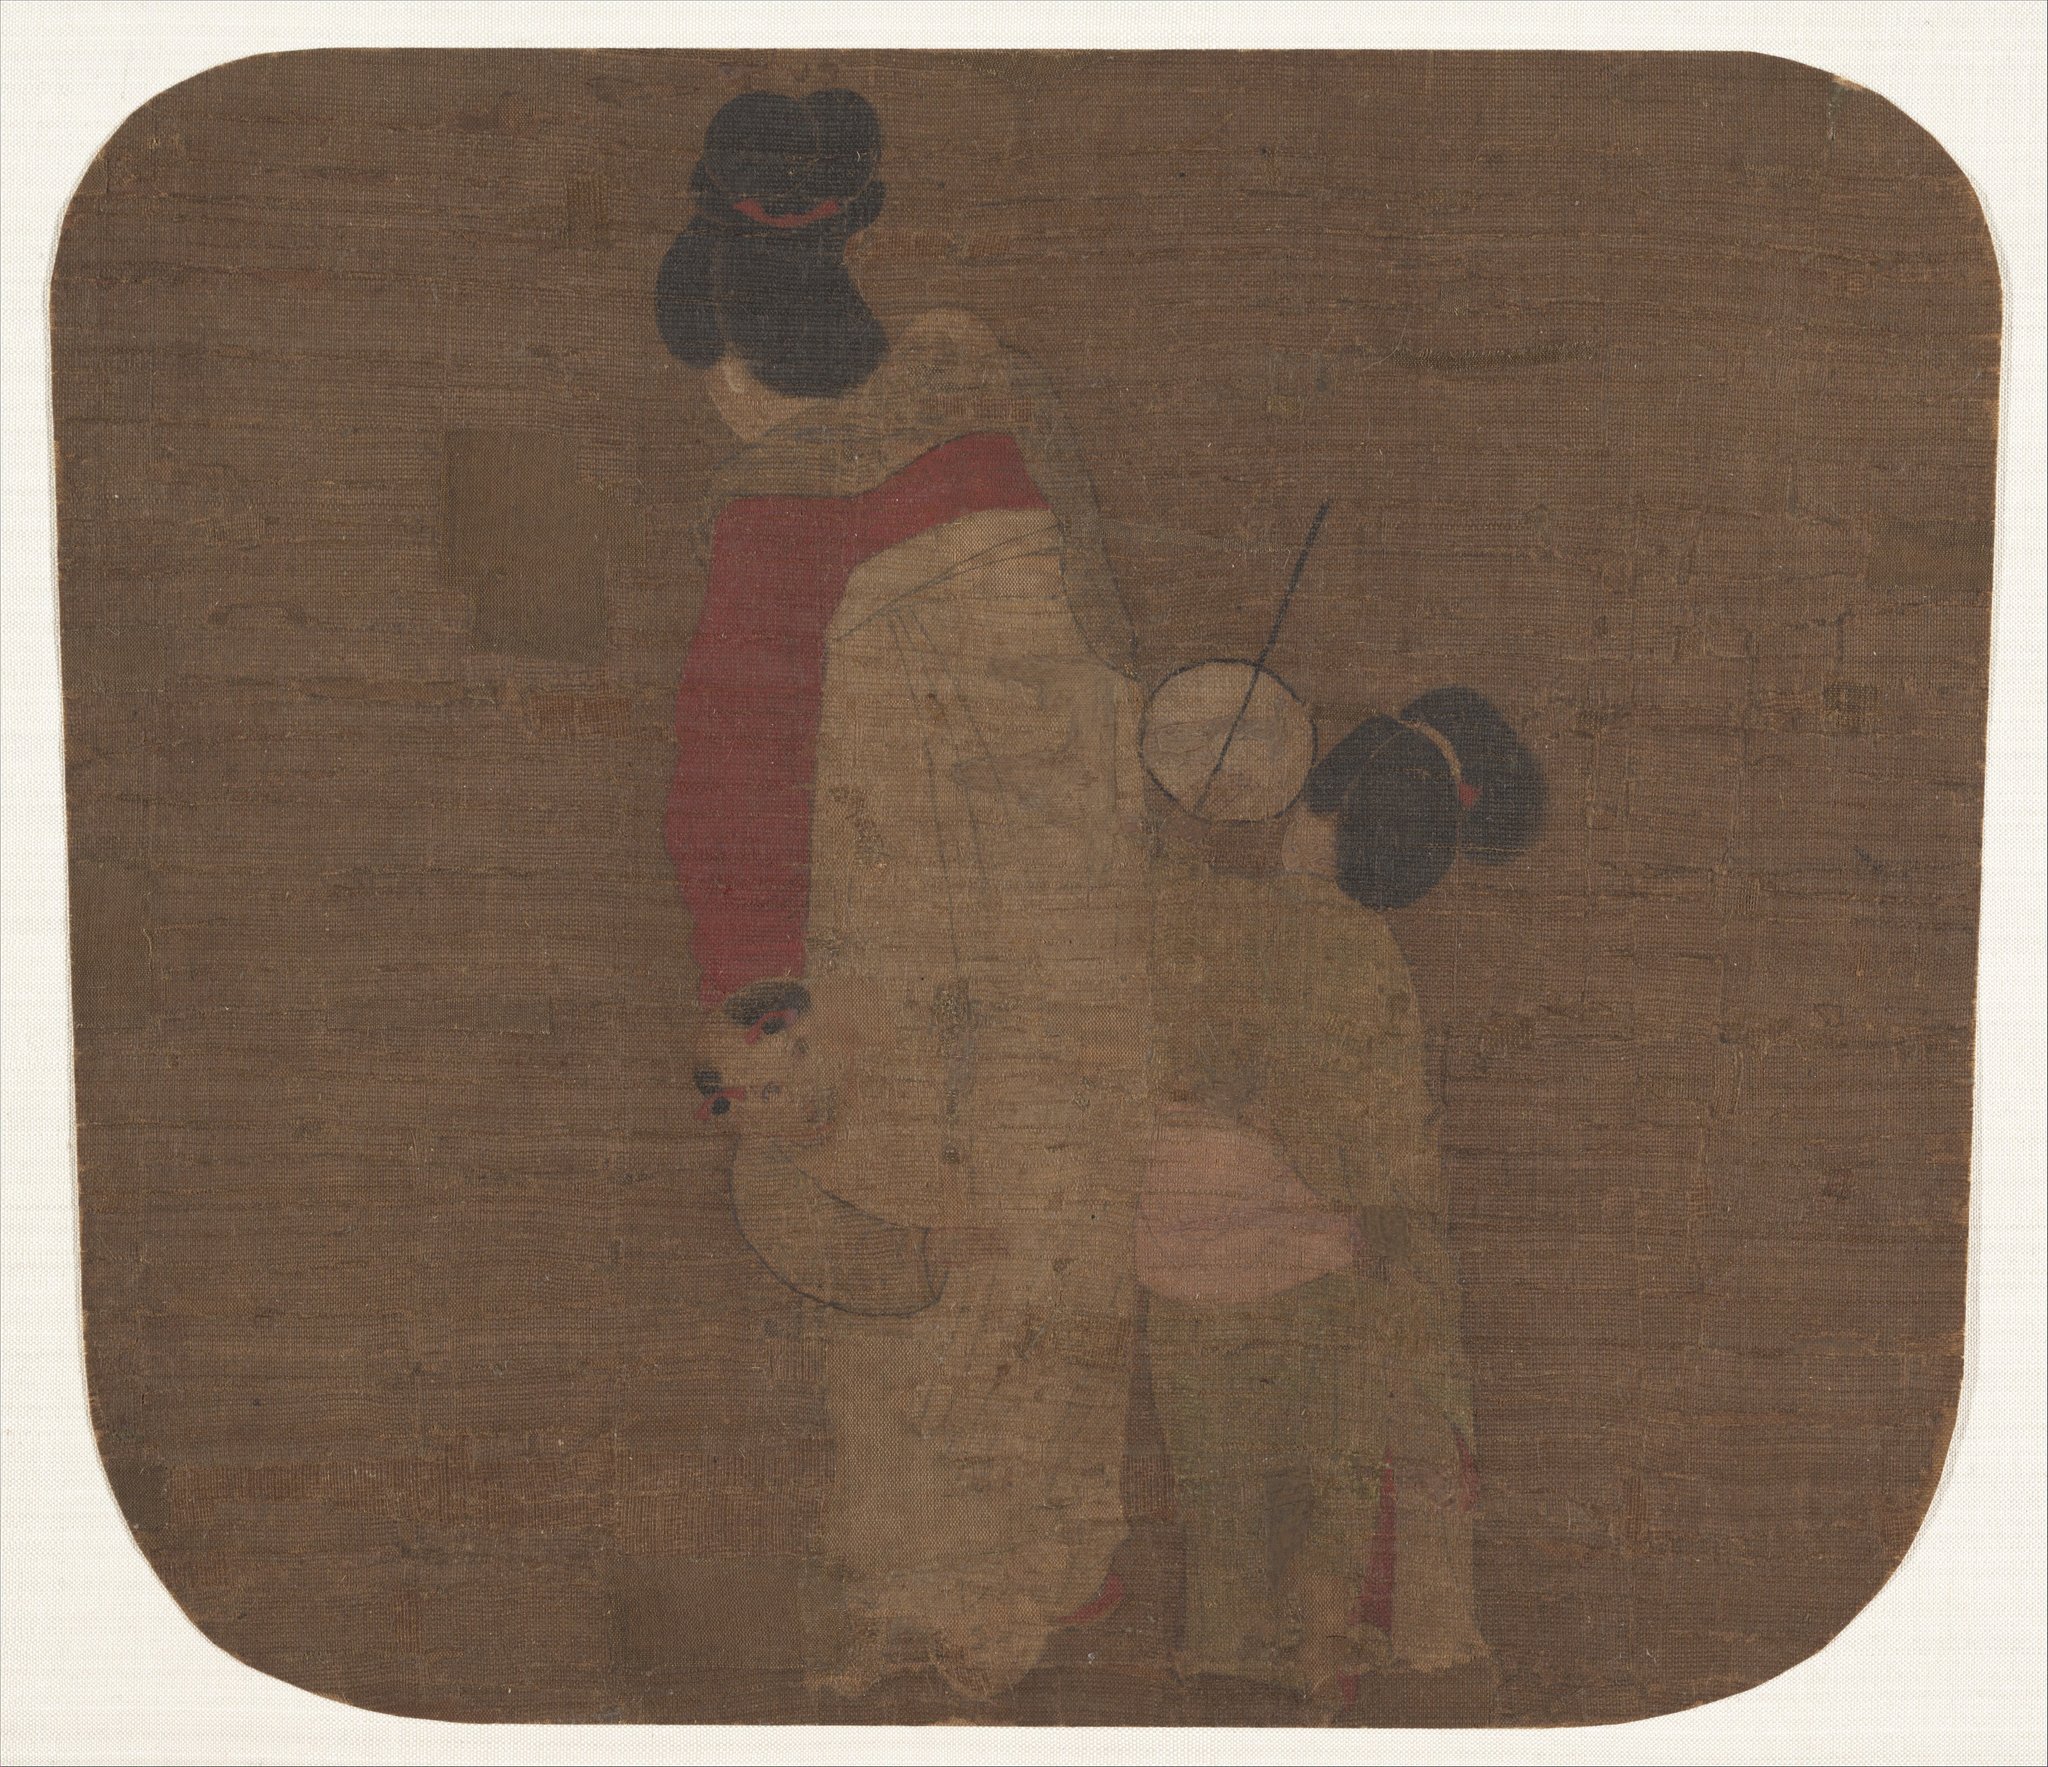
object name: album leaf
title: Lady and Children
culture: chinese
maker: unidentified artist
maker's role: artist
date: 1368-1644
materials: ink, silk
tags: girls,women